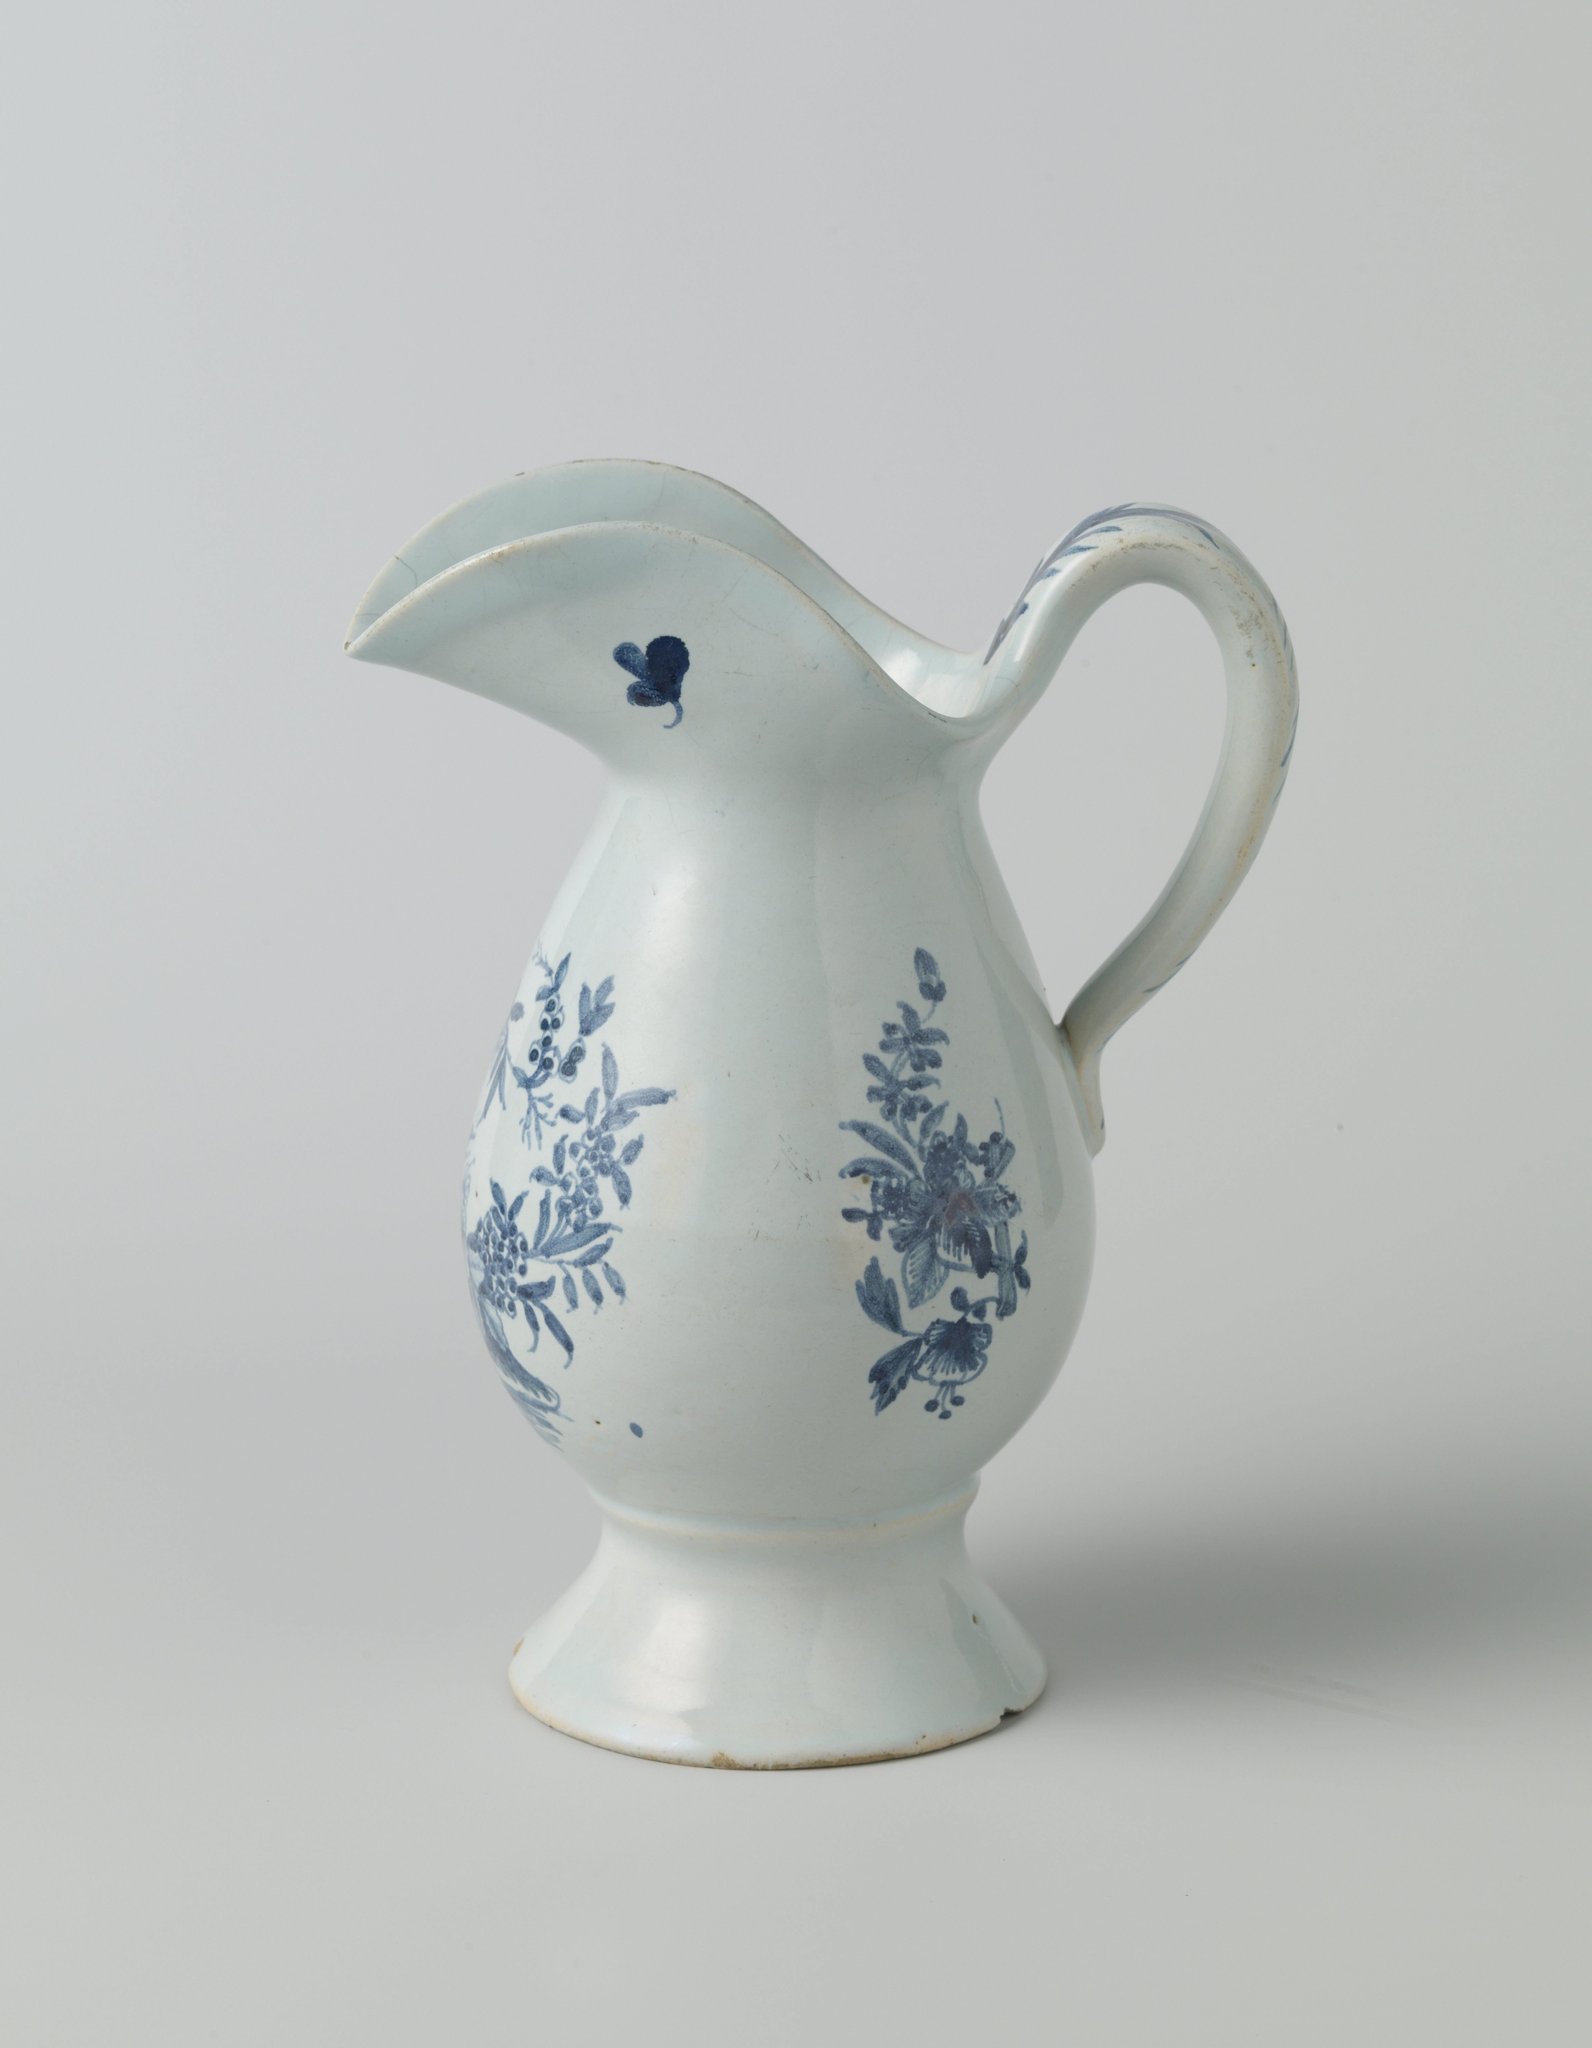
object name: ewer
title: Lampetkan, beschilderd met bloemen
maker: Anonymous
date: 1770-1800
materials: earthenware, glaze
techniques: painted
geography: england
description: Lampetkan van blauw beschilderde faience, op een lichtblauwe fond. De kan is ei-vormig, heeft een brede lip, een c-vormig oor en staat op een hoge, brede voet. De kan is beschilderd met bloemen.